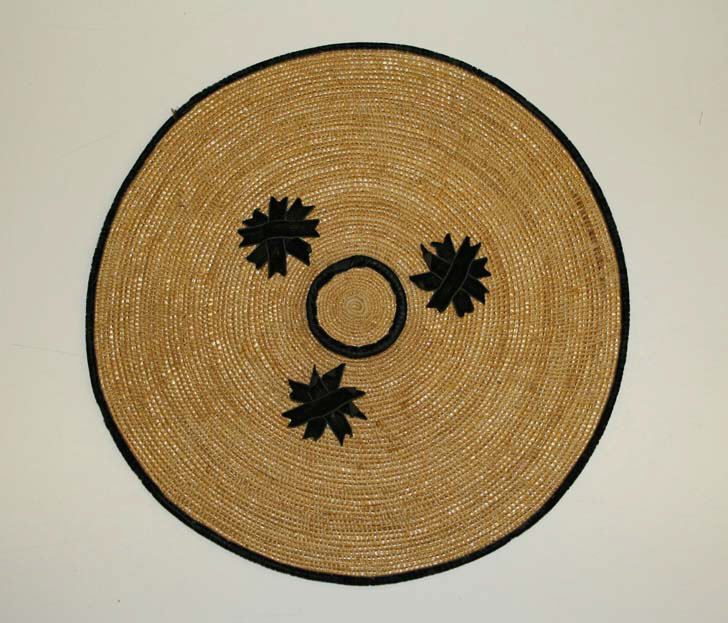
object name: hat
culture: american or european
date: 1870-1879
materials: silk, fiber